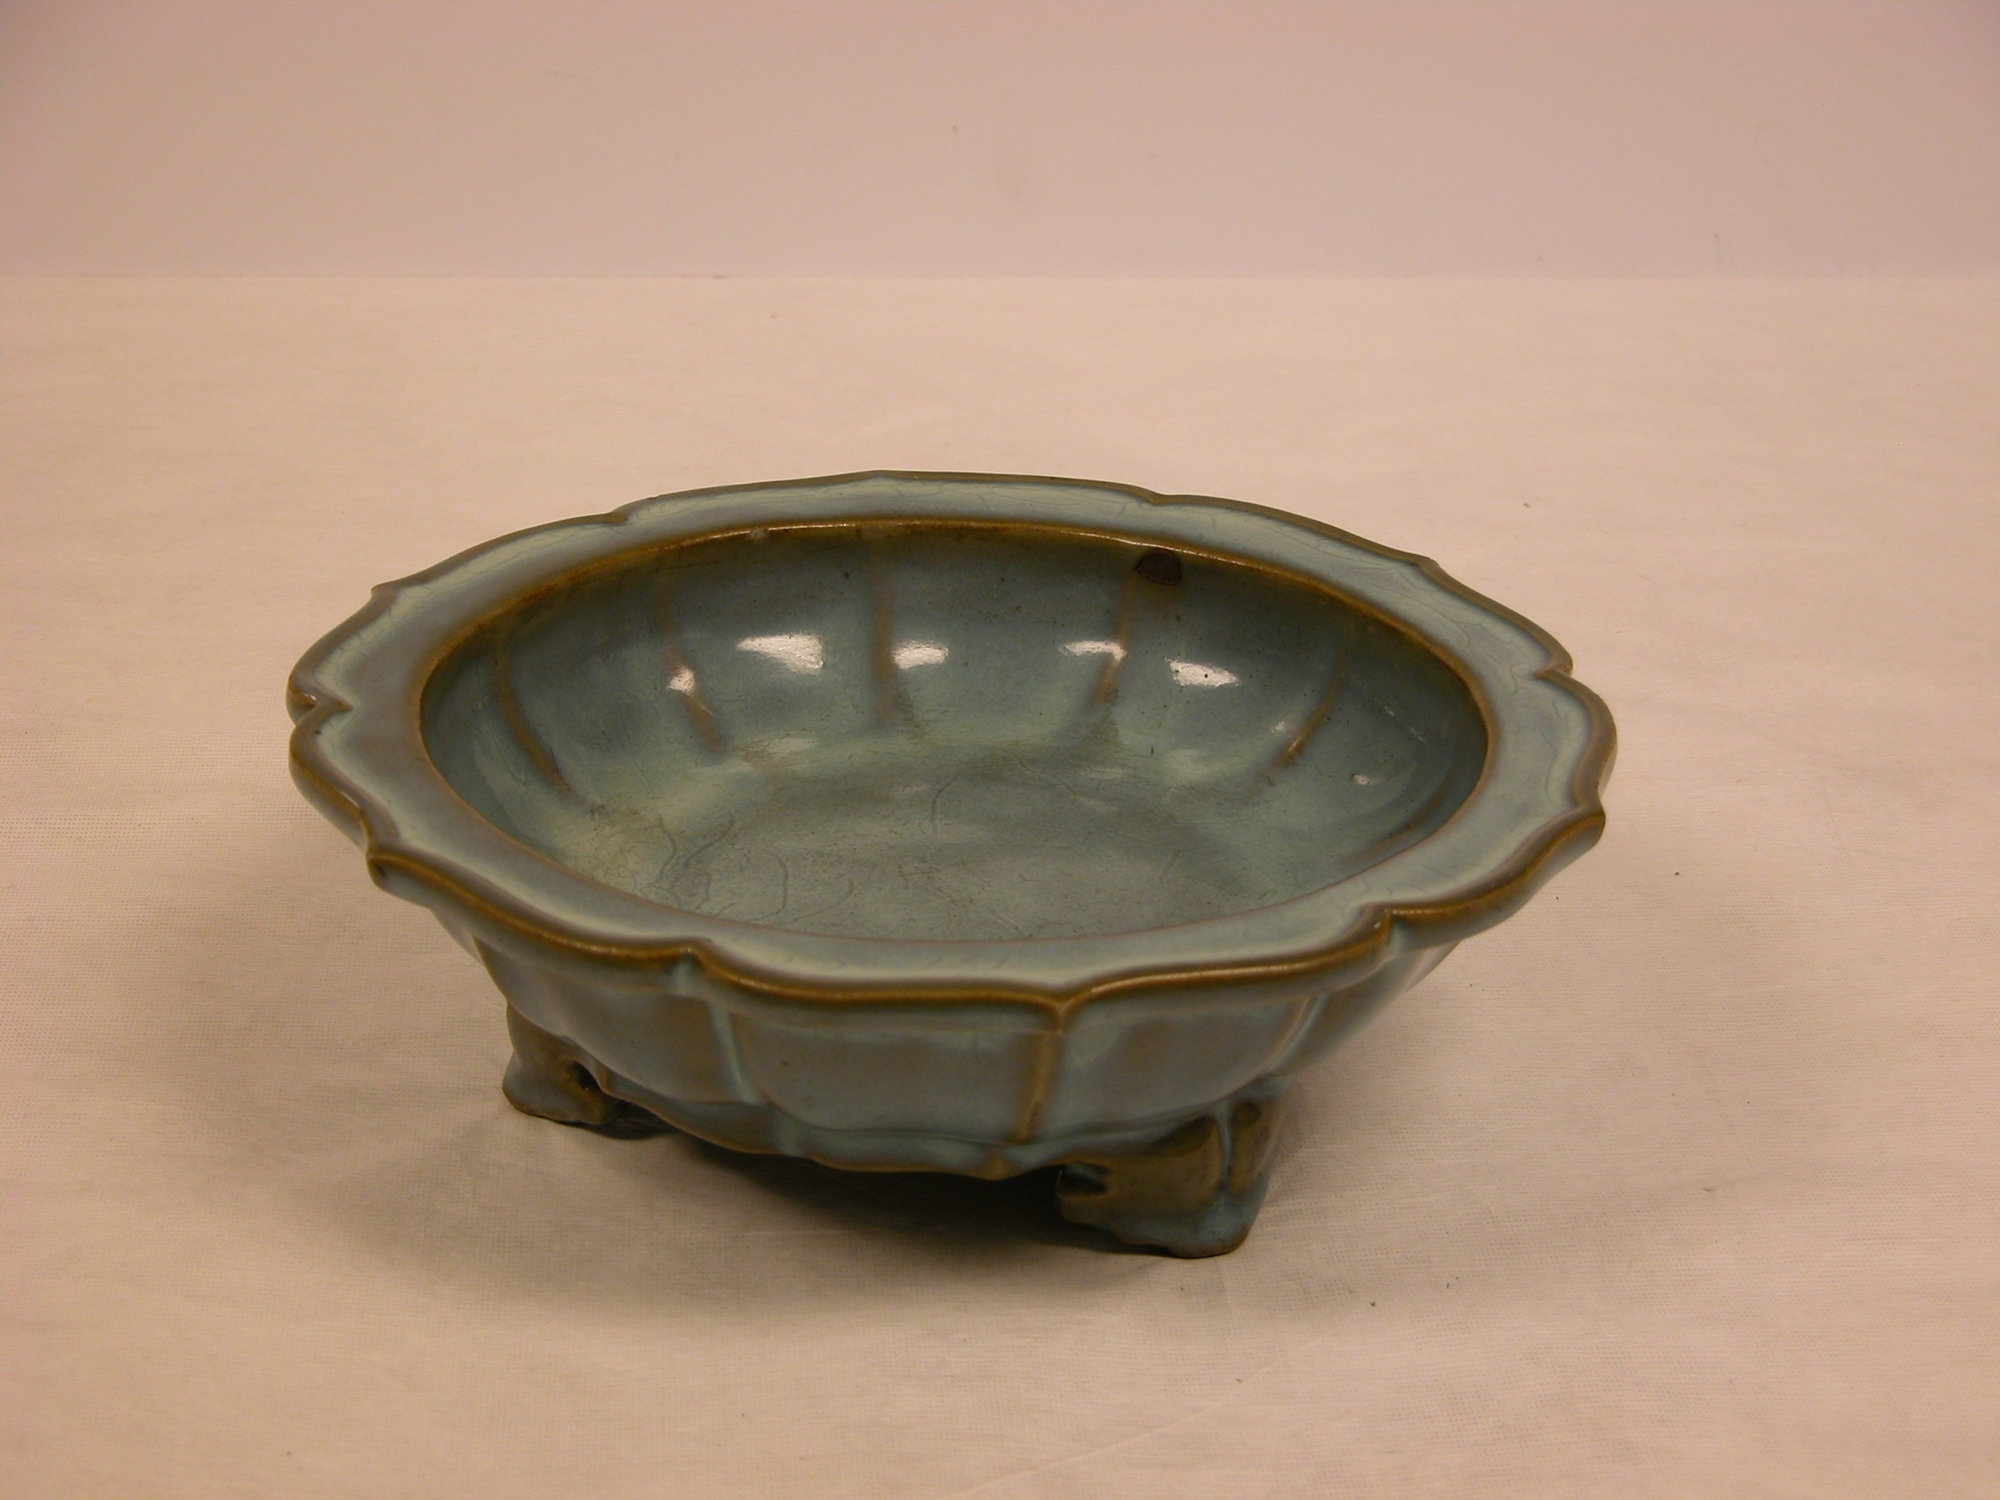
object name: bowl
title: Bulb Bowl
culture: chinese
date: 1368-1644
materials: glaze, stoneware